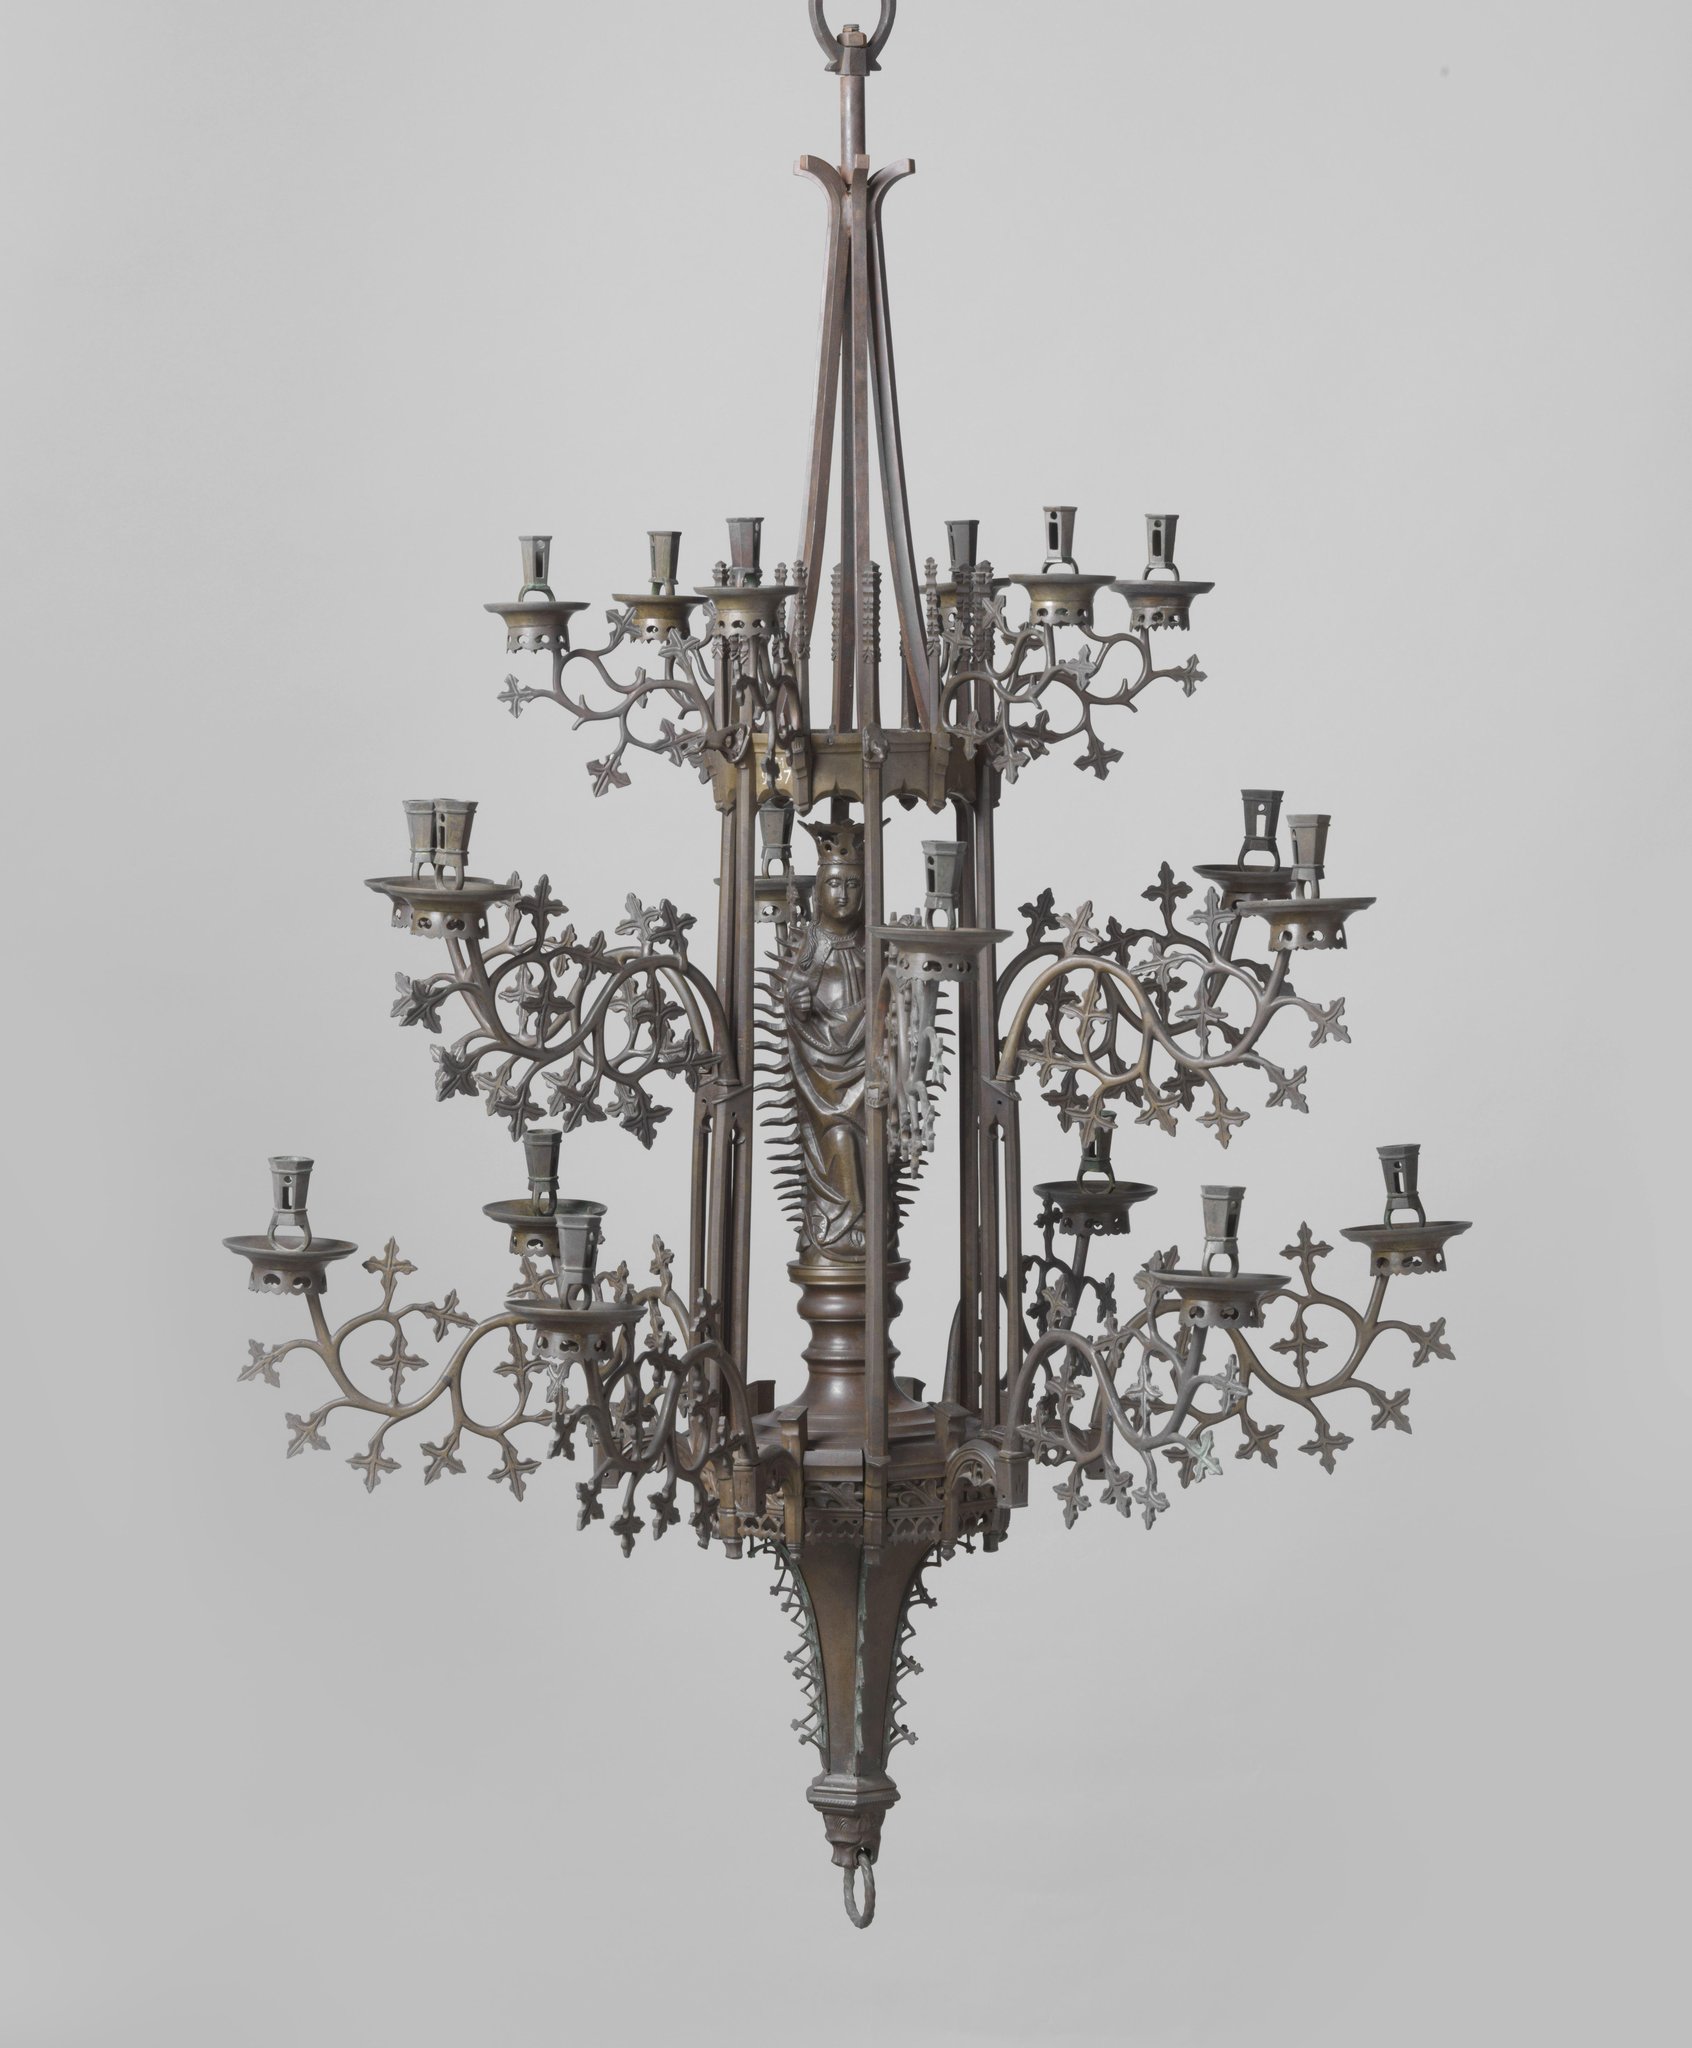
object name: kaarsenarm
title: Kaarsenarm van kaarsenkroon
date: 1475-1485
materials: brass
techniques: casting, metalworking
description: Kaarsenarm behorende bij een kaarsenkroon van drie hoogten met Mariakapel in het midden. De arm is twee maal gebogen en heeft elf bladeren. Aan het uiteinde rust de vetvanger, die aan de onderzijde een verticale gekartelde rand met kruisbloemmotieven heeft. De kaarsenhouder is zesvlakkig met een geperforeerde zijde aan voor- en achterkant en heeft een verticaal ringvormig onderstuk. Dit is de zesde arm van de middelste ring (midden van de spijlen), genummerd met 6 stippen.